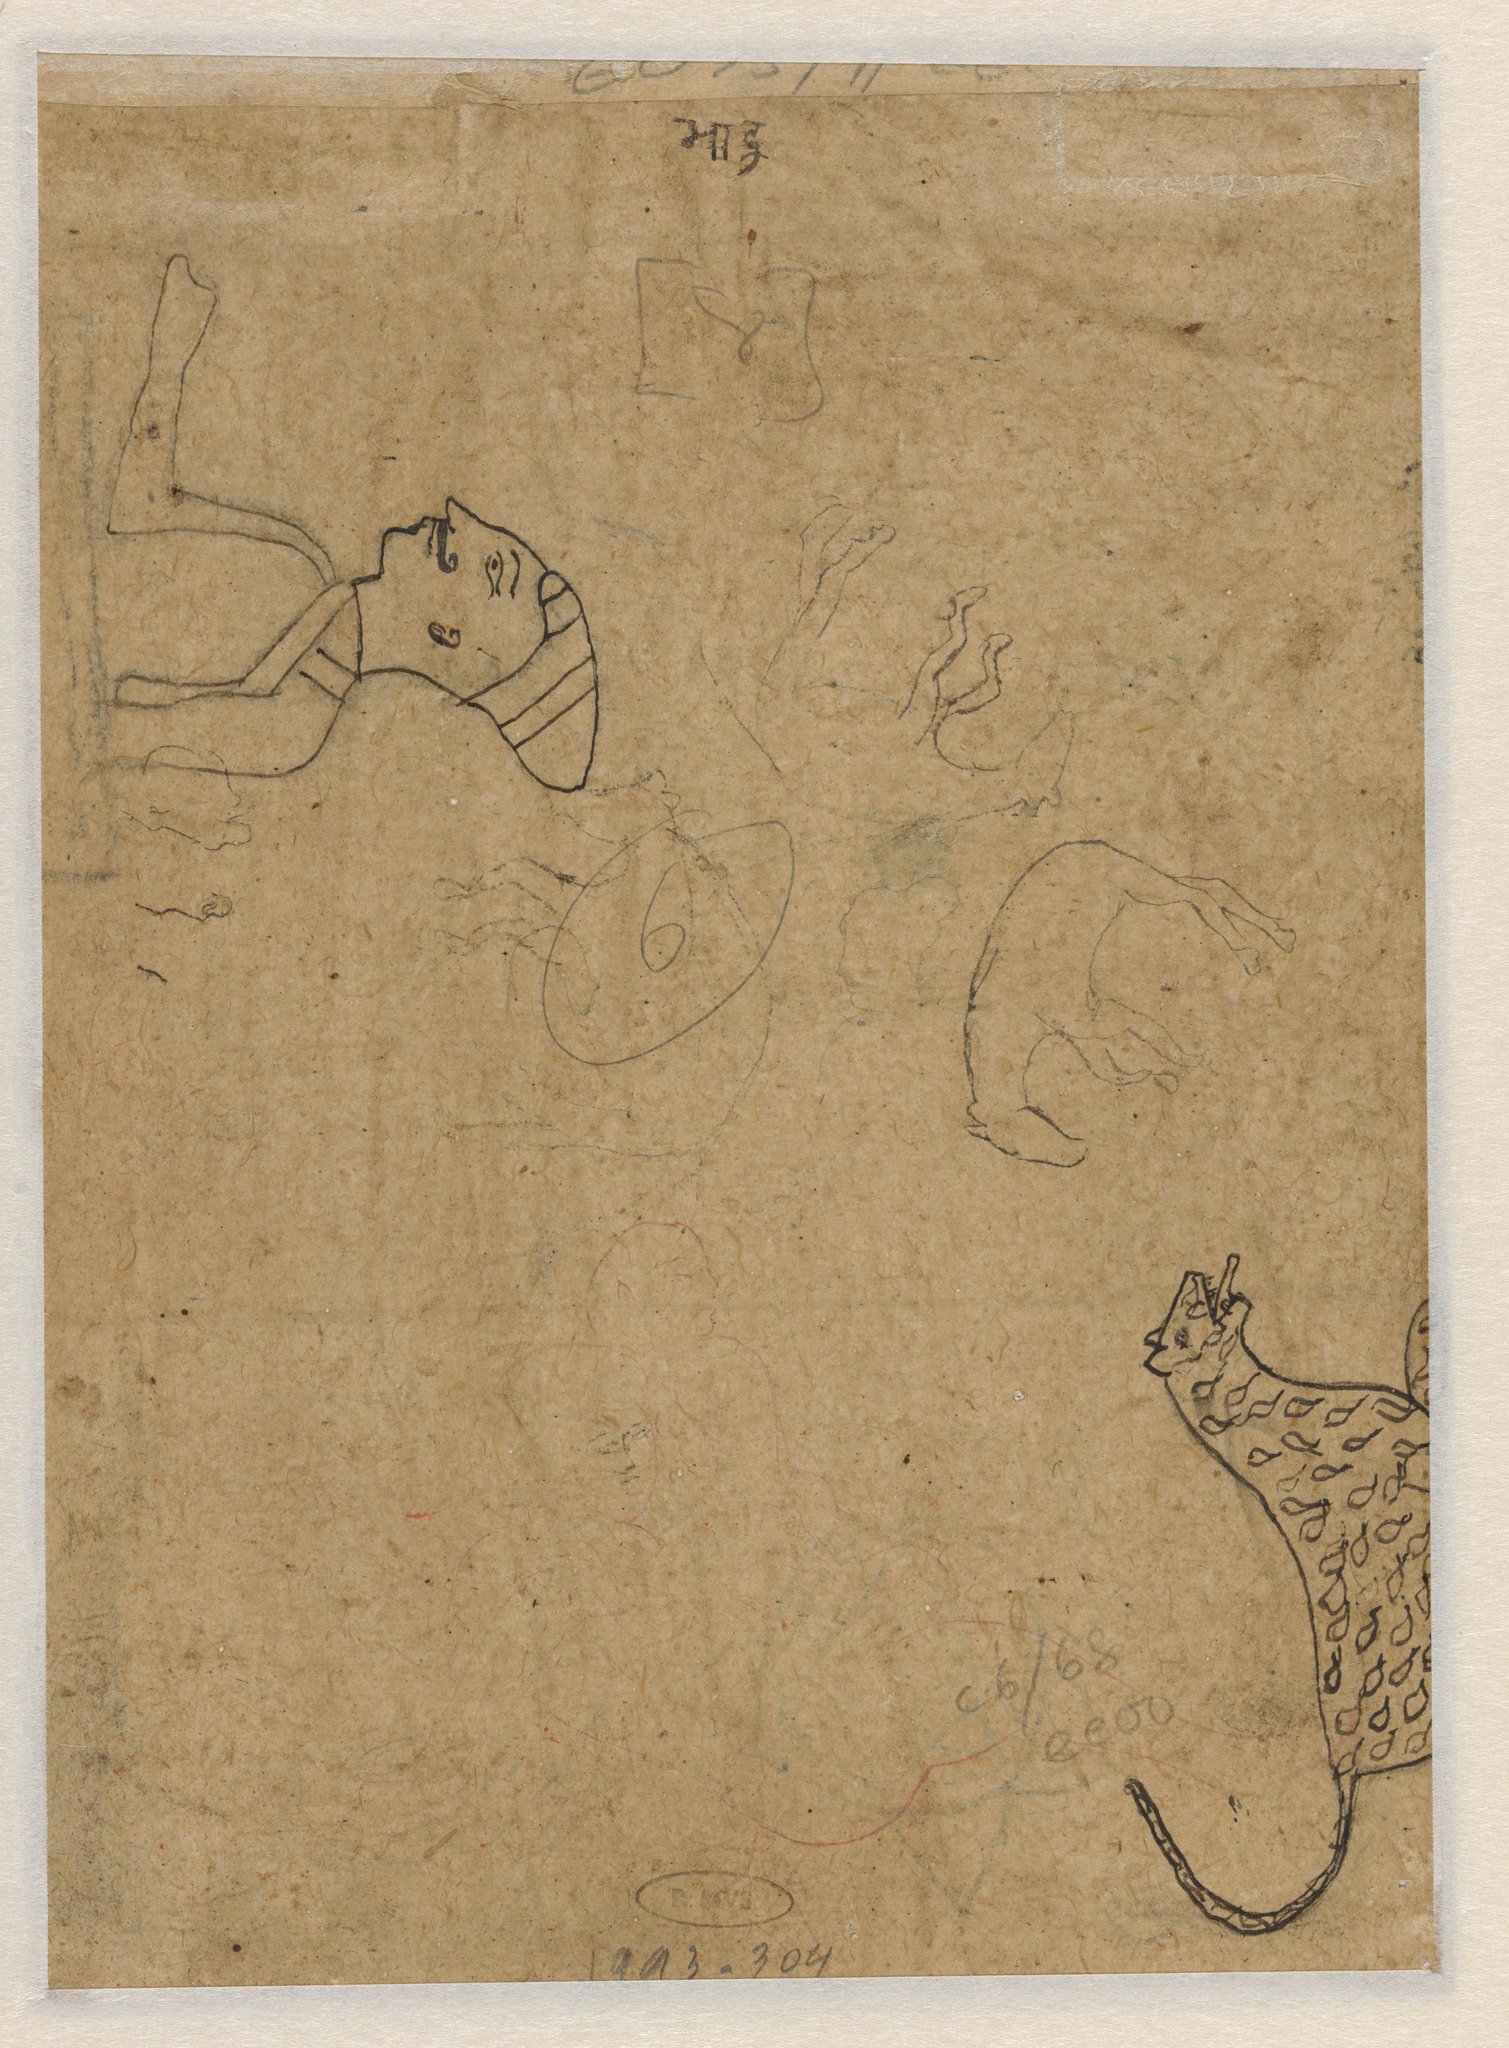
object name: indian miniature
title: Schetsen van dieren en een halve mansfiguur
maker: Anonymous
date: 1830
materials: paper, pencil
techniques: brush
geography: kangra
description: Een luipaard en de omtrek van een paar andere dieren of delen daarvan samen met een borstbeeld van een man met een muts.